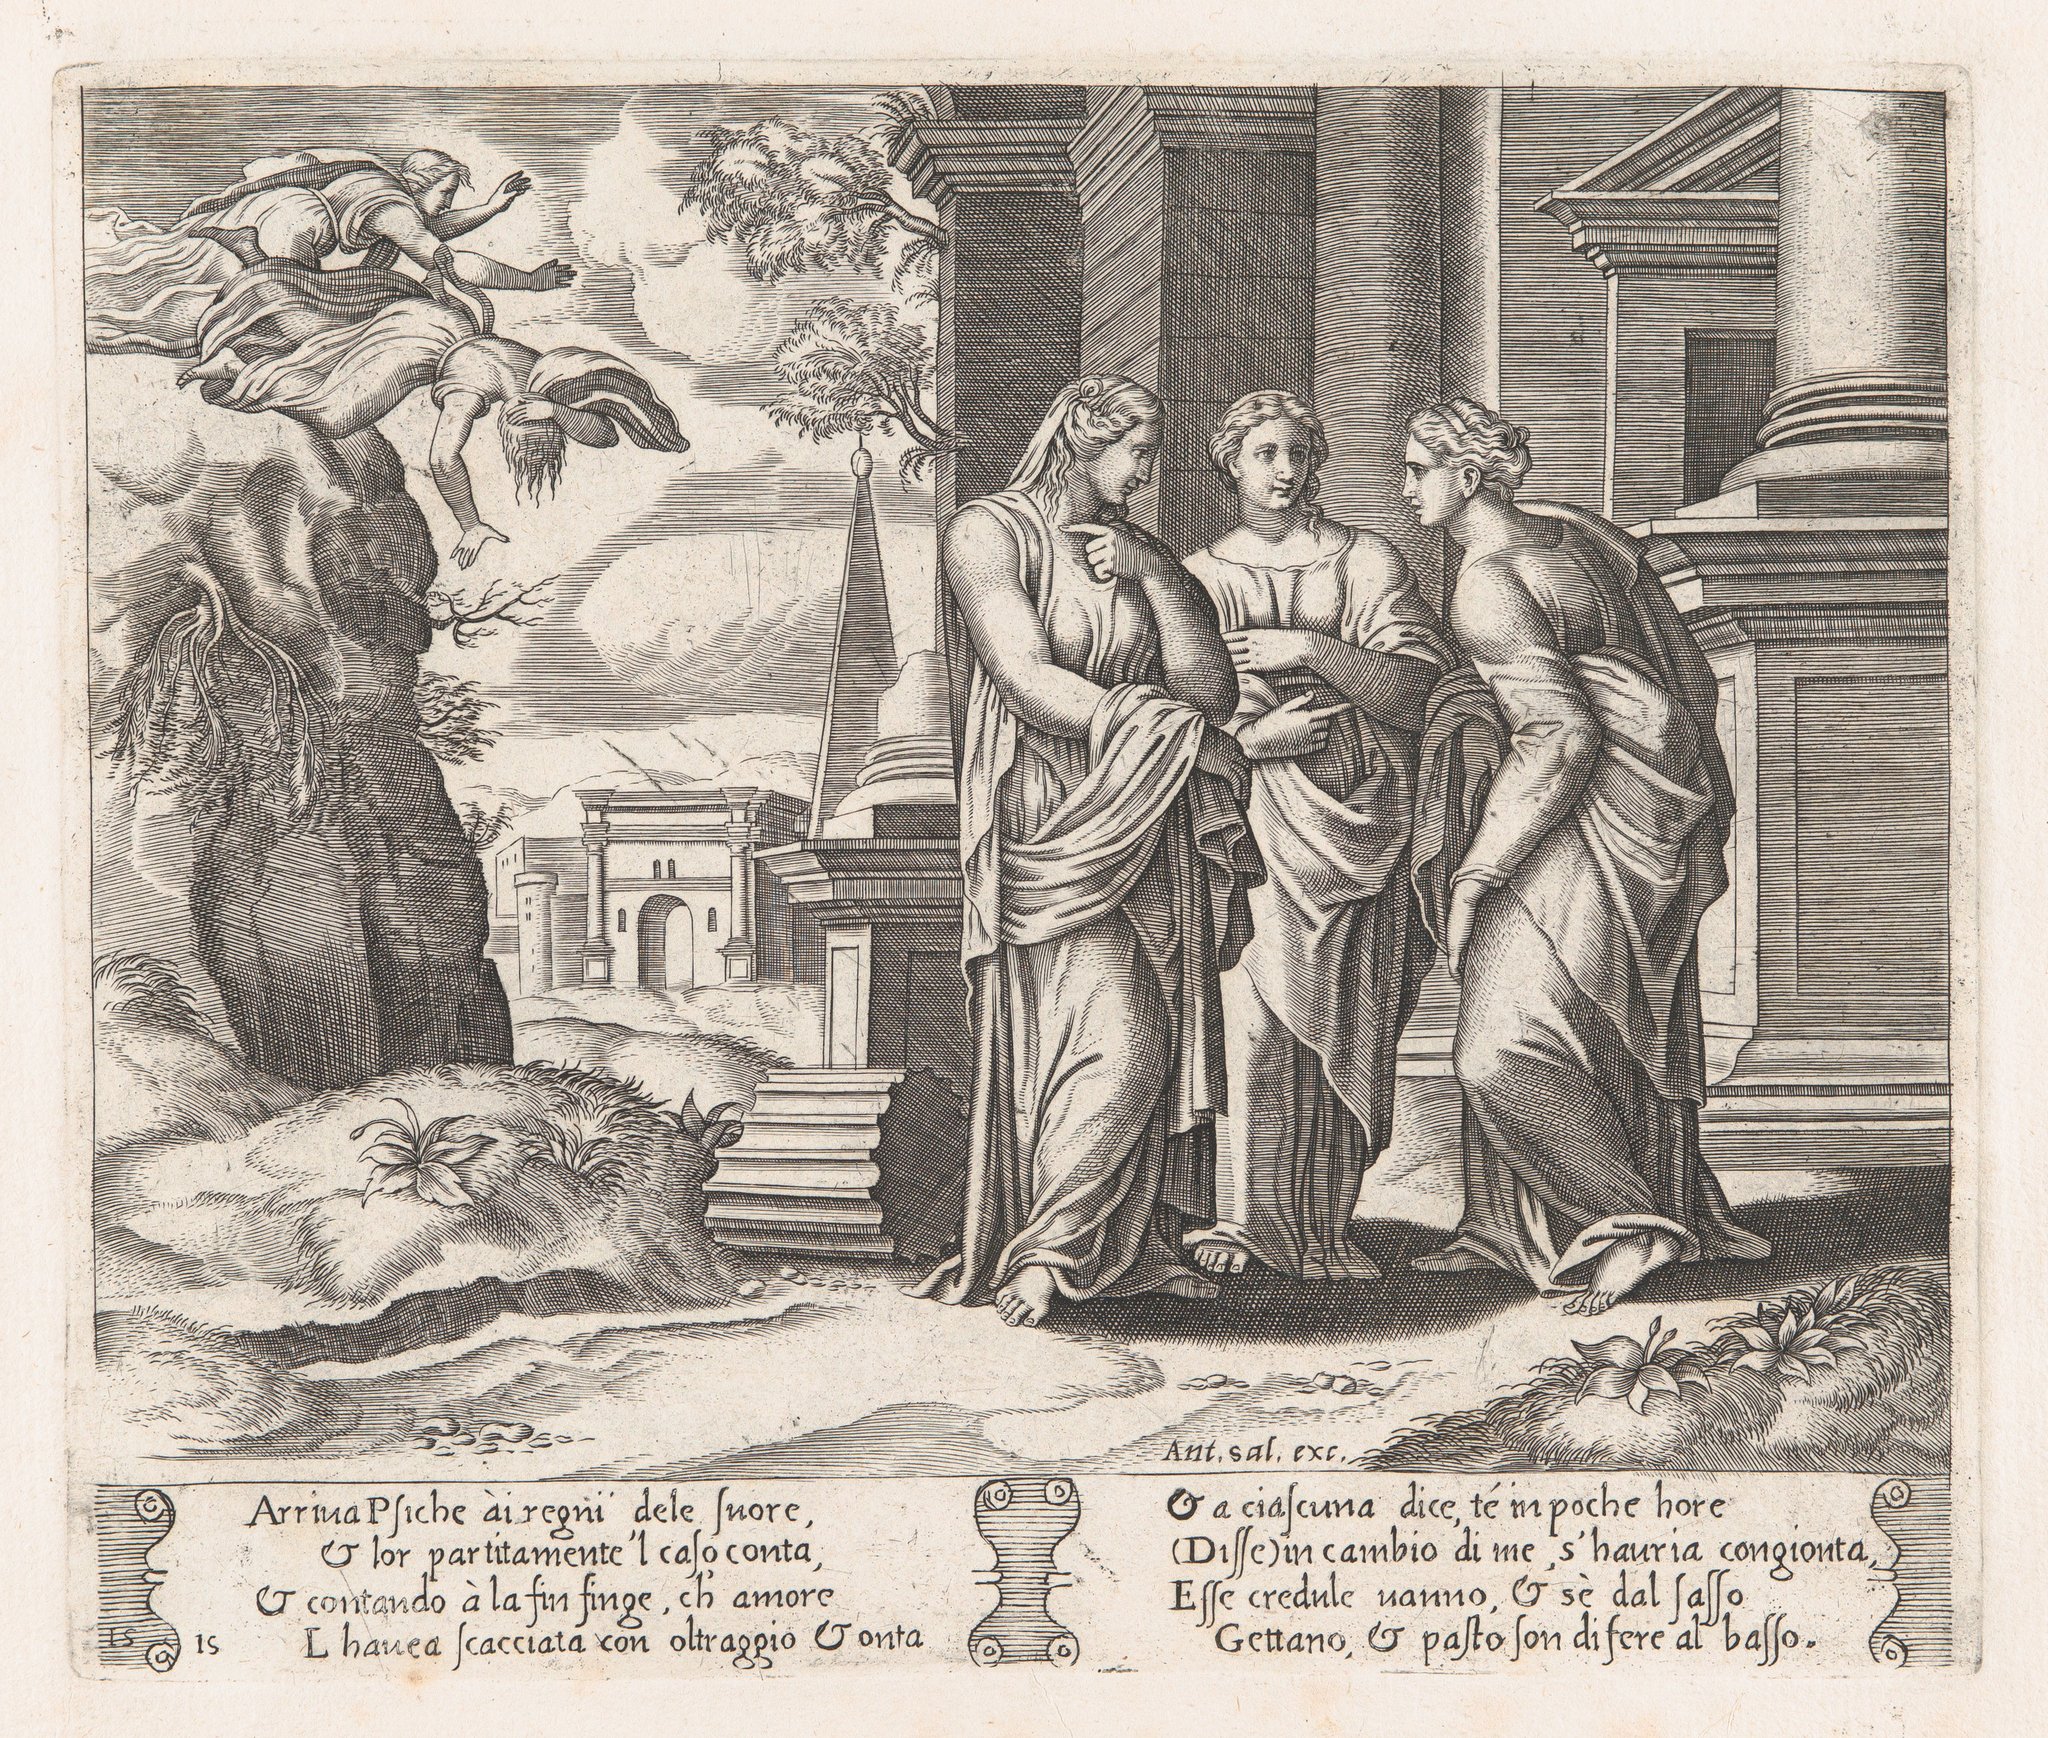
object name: print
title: Plate 15: Psyche telling her sisters about her misfortunes, with her sisters falling off of a precipice at upper left, from "The Story of Cupid and Psyche as told by Apuleius"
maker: master of the die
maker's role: artist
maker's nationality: italian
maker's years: 1525-1560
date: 1530-1560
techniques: engraving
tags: cupid,psyche